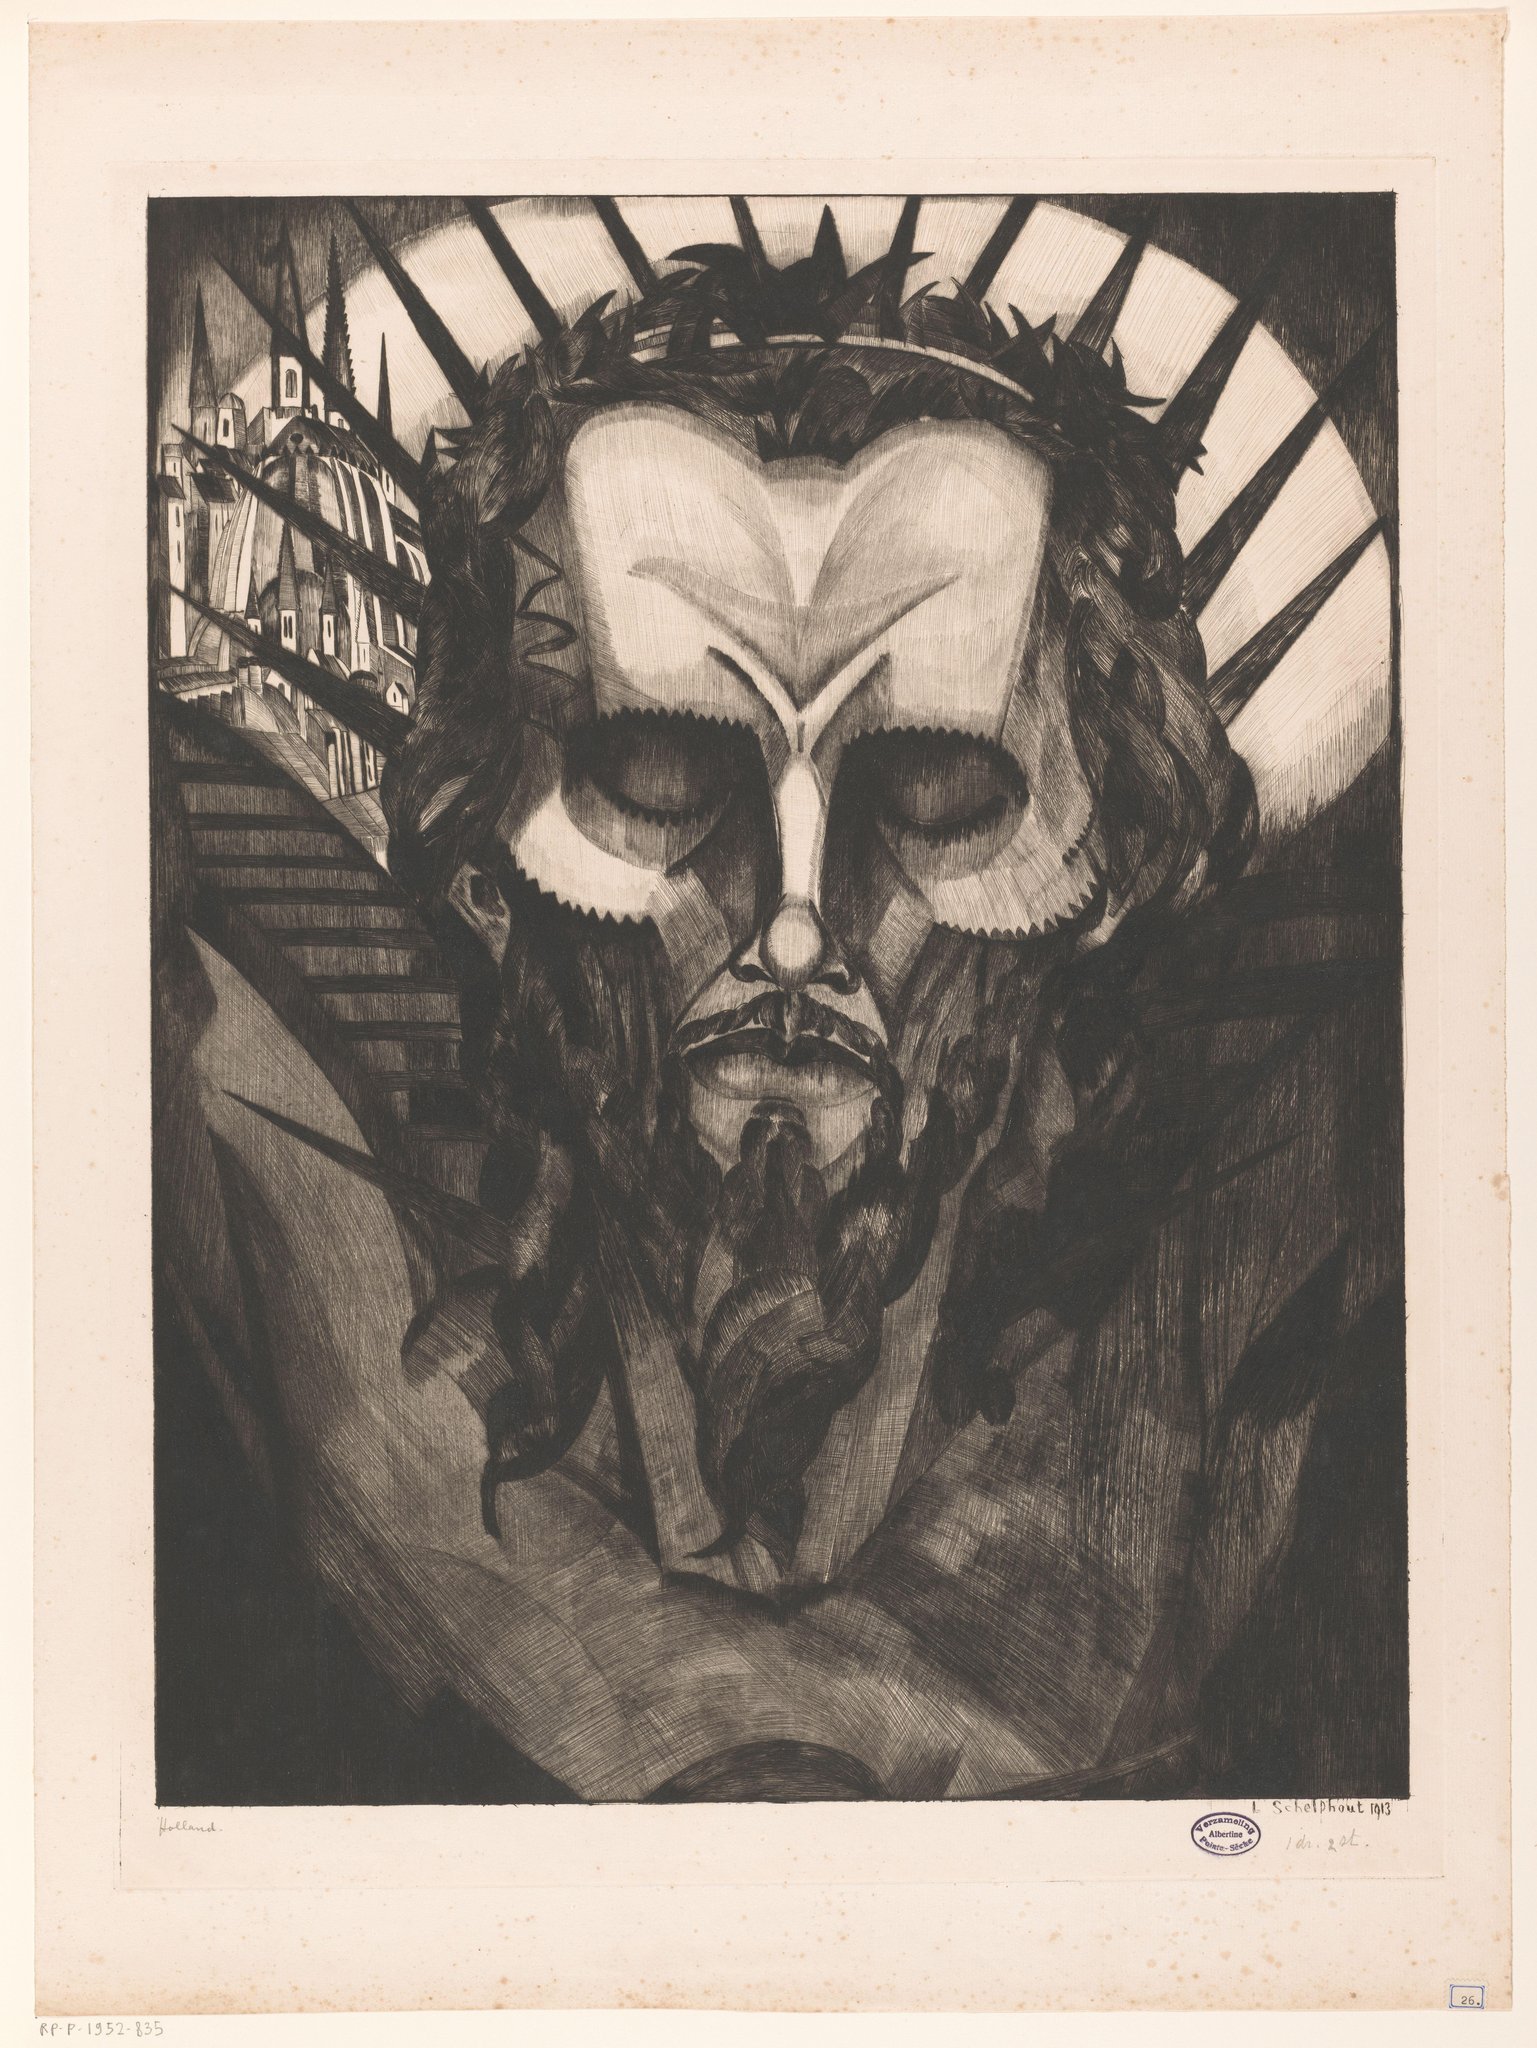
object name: print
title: Hoofd van Christus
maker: lodewijk schelfhout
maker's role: draughtsman, print maker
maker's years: 1881-1943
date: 1913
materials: paper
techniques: drypoint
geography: netherlands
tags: landscape with tower or castle, crown of thorns ~ instruments of the passion, eyes closed, 'portraits' of christ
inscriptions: collector's mark: Lugt 5i, collector's mark: Lugt 2760, collector's mark: Lugt 2228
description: Christus met doornenkroon en gesloten ogen. Links op de achtergrond gebouwen met torens.